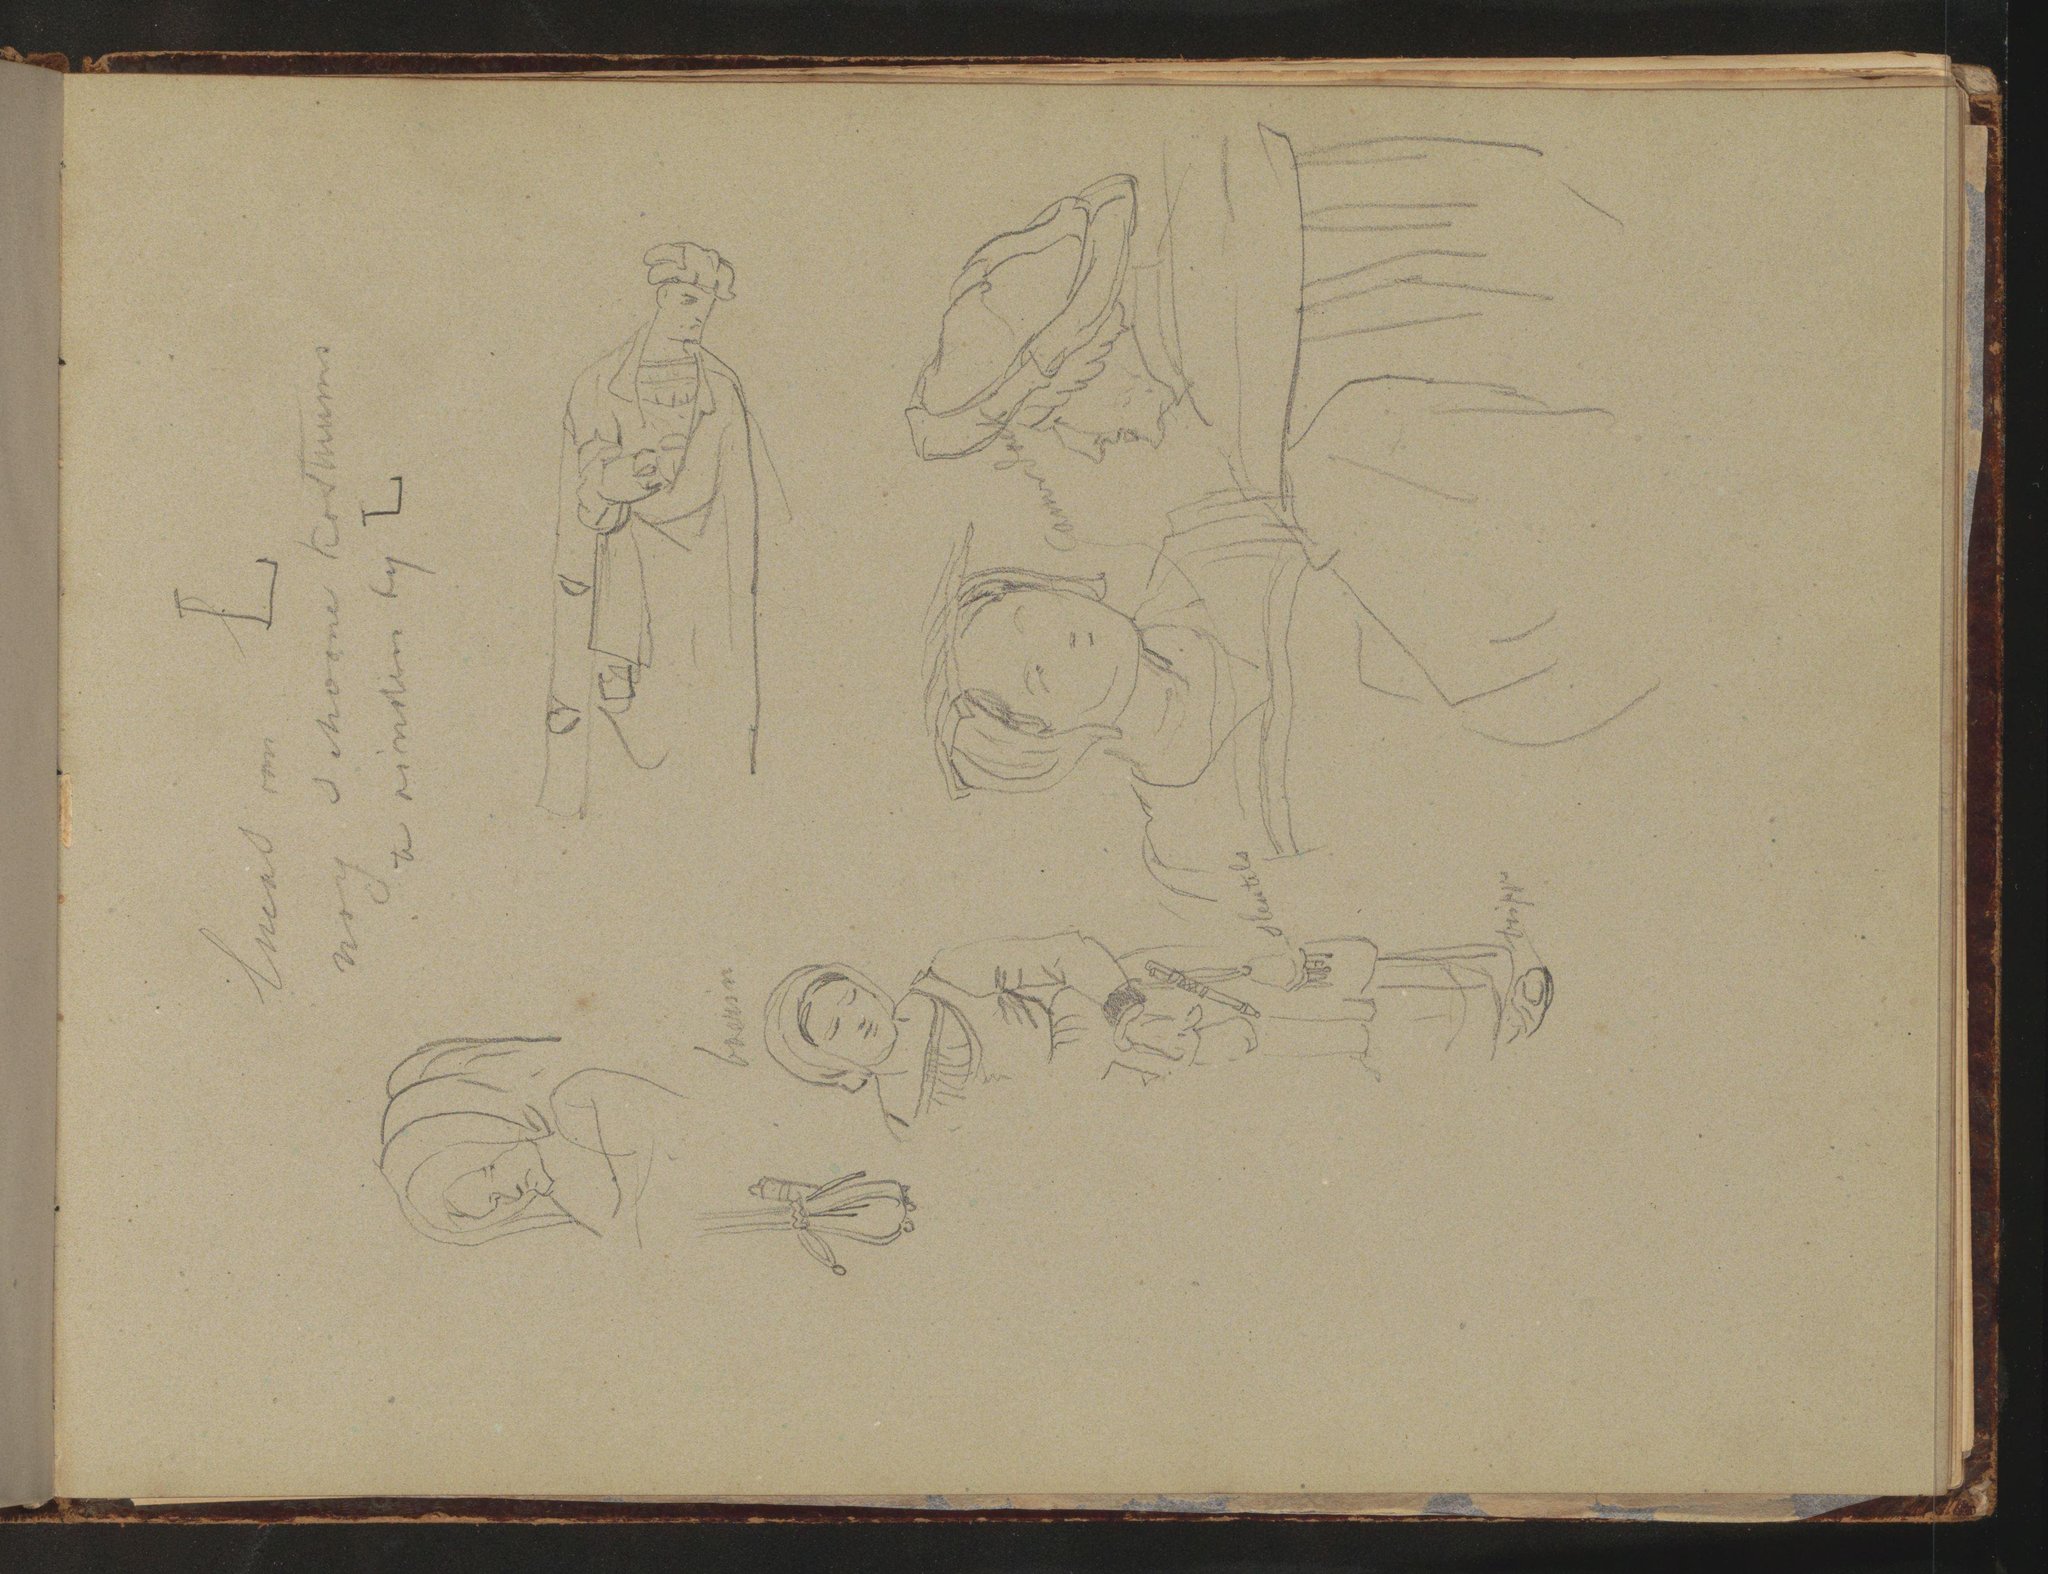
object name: sketchbook leaf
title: Figuren, waaronder een boerin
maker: reinier craeyvanger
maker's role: draughtsman, print maker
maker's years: 1812-1880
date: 1822-1880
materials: paper, pencil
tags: head (human), standing figure - aa - female human figure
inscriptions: annotation: ‘Lucas van L/ nog schoone kostuums/ te vinden bij L/ boerin/ sleutels/ t[...]p[...]/ camersack’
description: Blad 27 recto uit een schetsboek met 45 bladen.